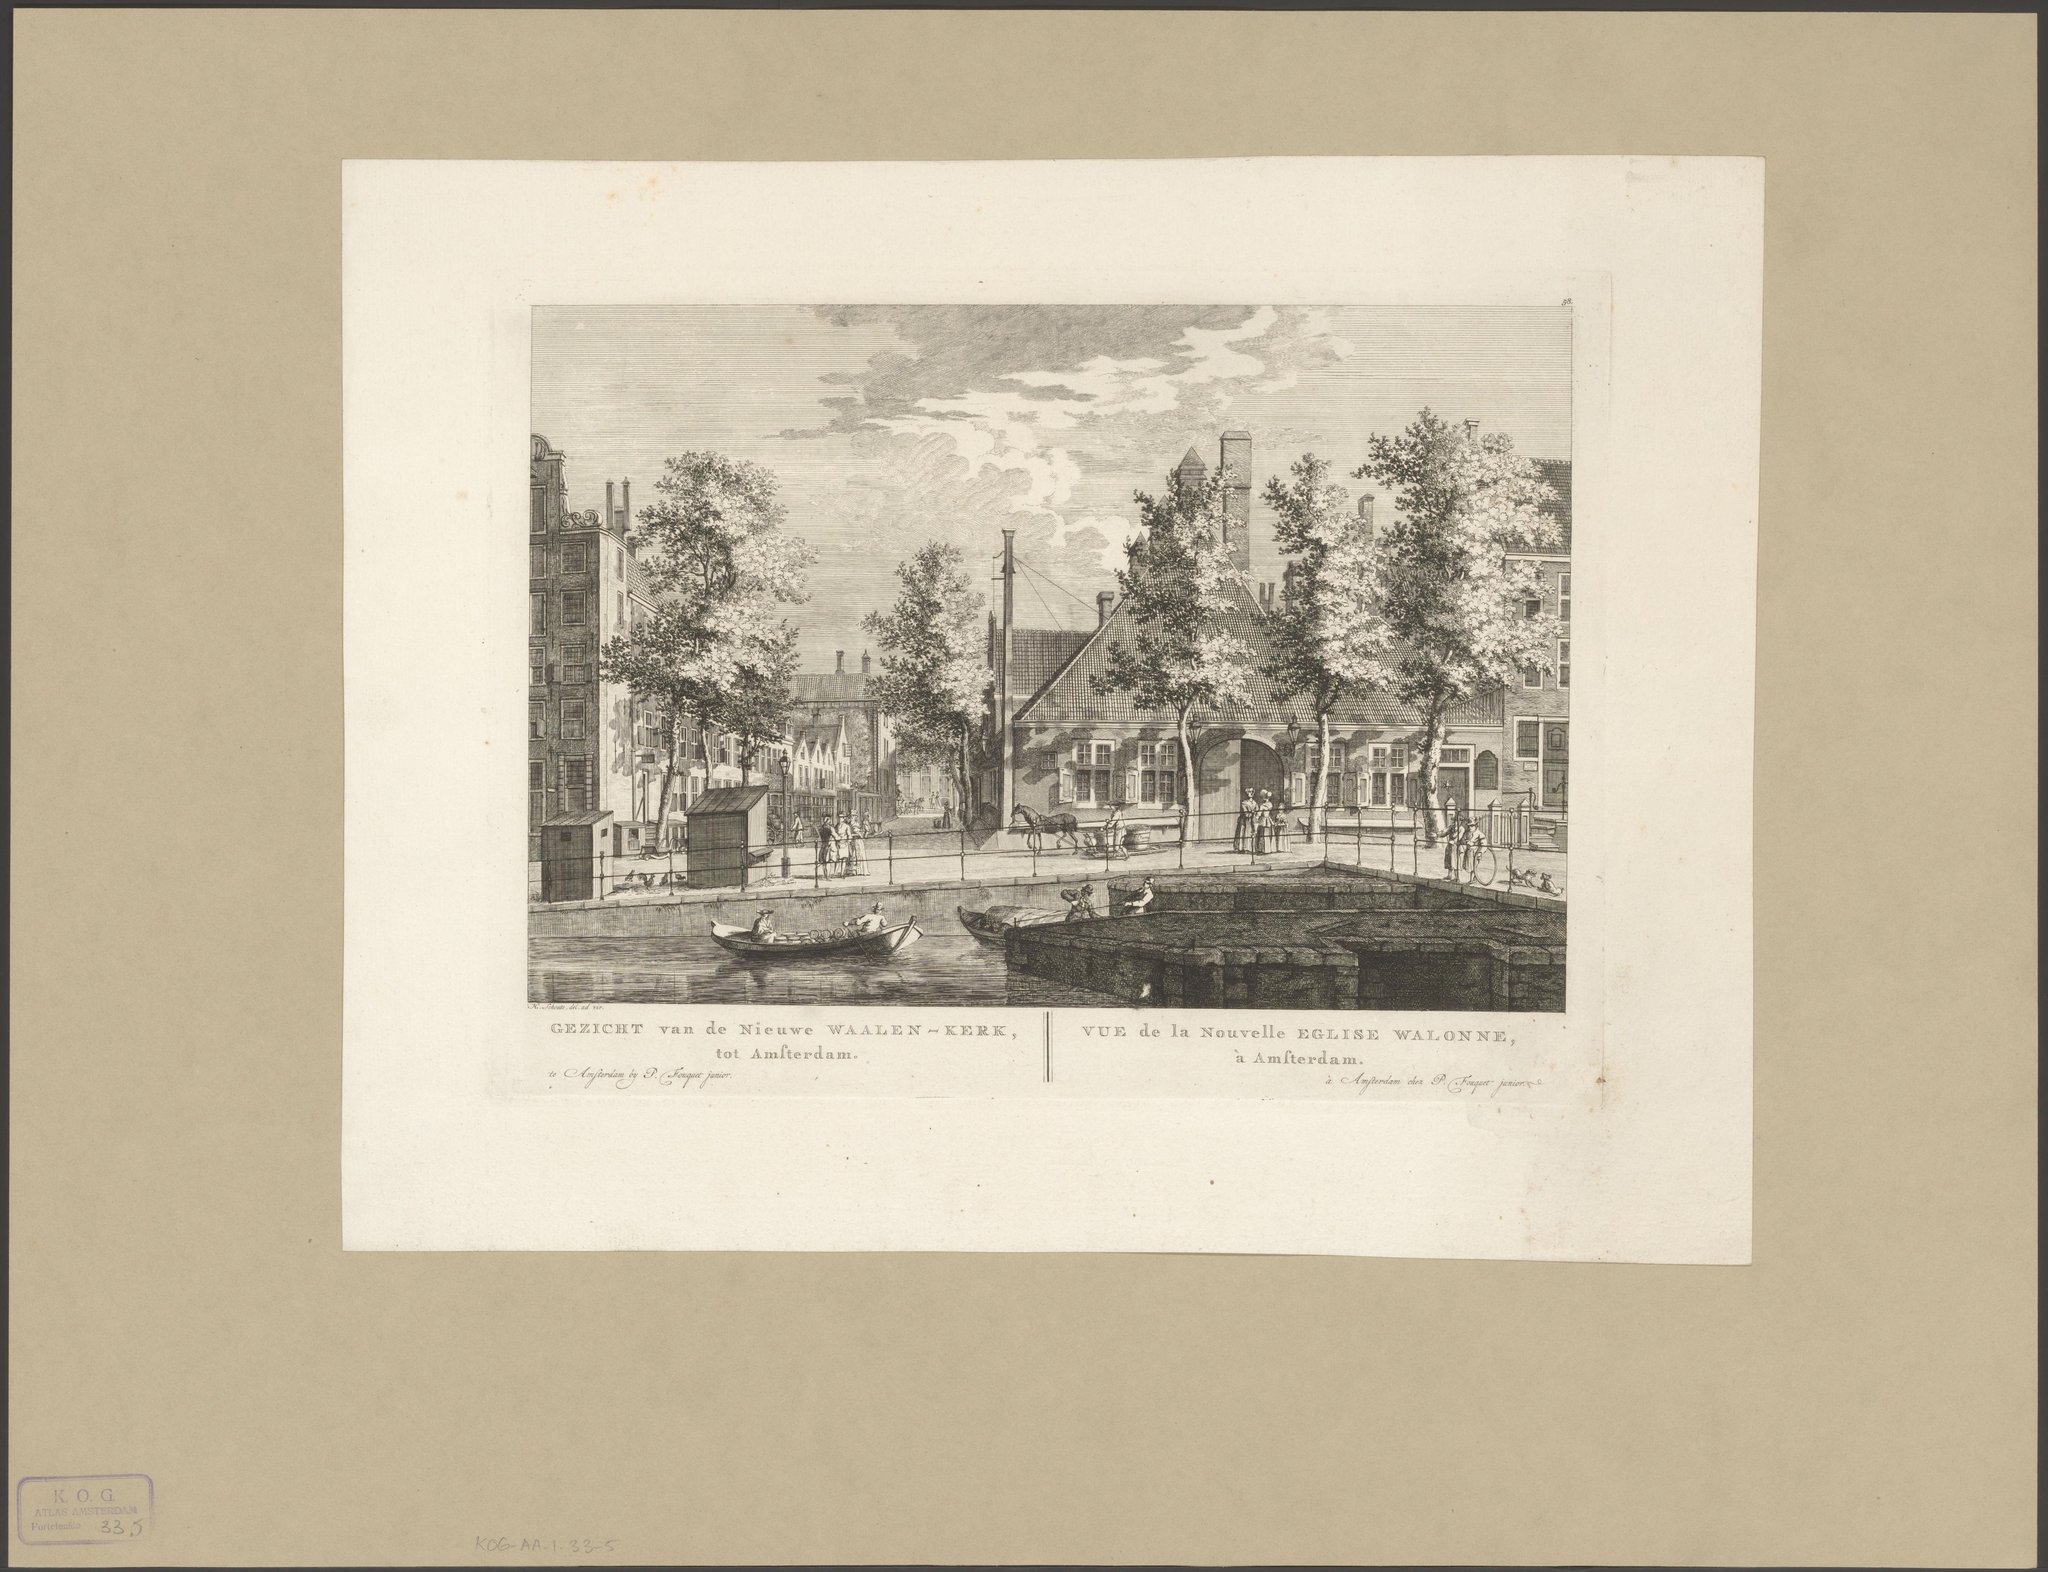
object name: print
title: Gezicht van de Nieuwe Waalen-Kerk, tot Amsterdam / Vue de la Nouvelle Eglise Walonne, à Amsterdam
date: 1770-1783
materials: paper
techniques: engraving, etching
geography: amsterdam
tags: church (exterior), rowing-boat, canoe, etc., canals, waters (in city) (+ city(-scape) with figures, staffage)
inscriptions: collector's mark: Lugt 1641b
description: Vanaf 1760 gaf Pierre Fouquet stadsgezichten van Amsterdam naar tekeningen van verschillende kunstenaars uit. Deze prenten werden aanvankelijk los verkocht. Later werden ze samengebonden verkocht in verschillende volgordes en aantallen in: (1). Afbeeldingen van de wyd-vermaarde koopstad Amsterdam benevens des zelvs voornaamste gebouwen en gezigten alle naar het leeven getekend / Receuil des edifices les plus considerables et des plus belles vues, de la fameuse ville d'Amsterdam, dessinées d'après nature. Amsterdam: Pierre Fouquet, 1778-1783. Deze 'uitgave' bestond waarschijnlijk alleen uit een titelblad en inhoudsopgave van de tot dusver 100 uitgegeven prenten, die de koper zelf aan zijn of haar reeds verzamelde prenten kon toevoegen. De hoeveelheid en volgorde van prenten verzameld onder deze titel verschilt dus sterk. (2). Nieuwe atlas, van de voornaamste gebouwen en gezigten der stad Amsterdam, met derzelver beknopte beschryvingen. 2 dln. Amsterdam: Daniël Jean Changuion en Petrus den Hengst [in opdracht van Pierre Fouquet], 1783. Ook werden er door verschillende uitgevers tussen 1788 (Amsterdam: Petrus Conradi) en 1805 (Amsterdam: Evert Maaskamp) heruitgaven gepubliceerd.